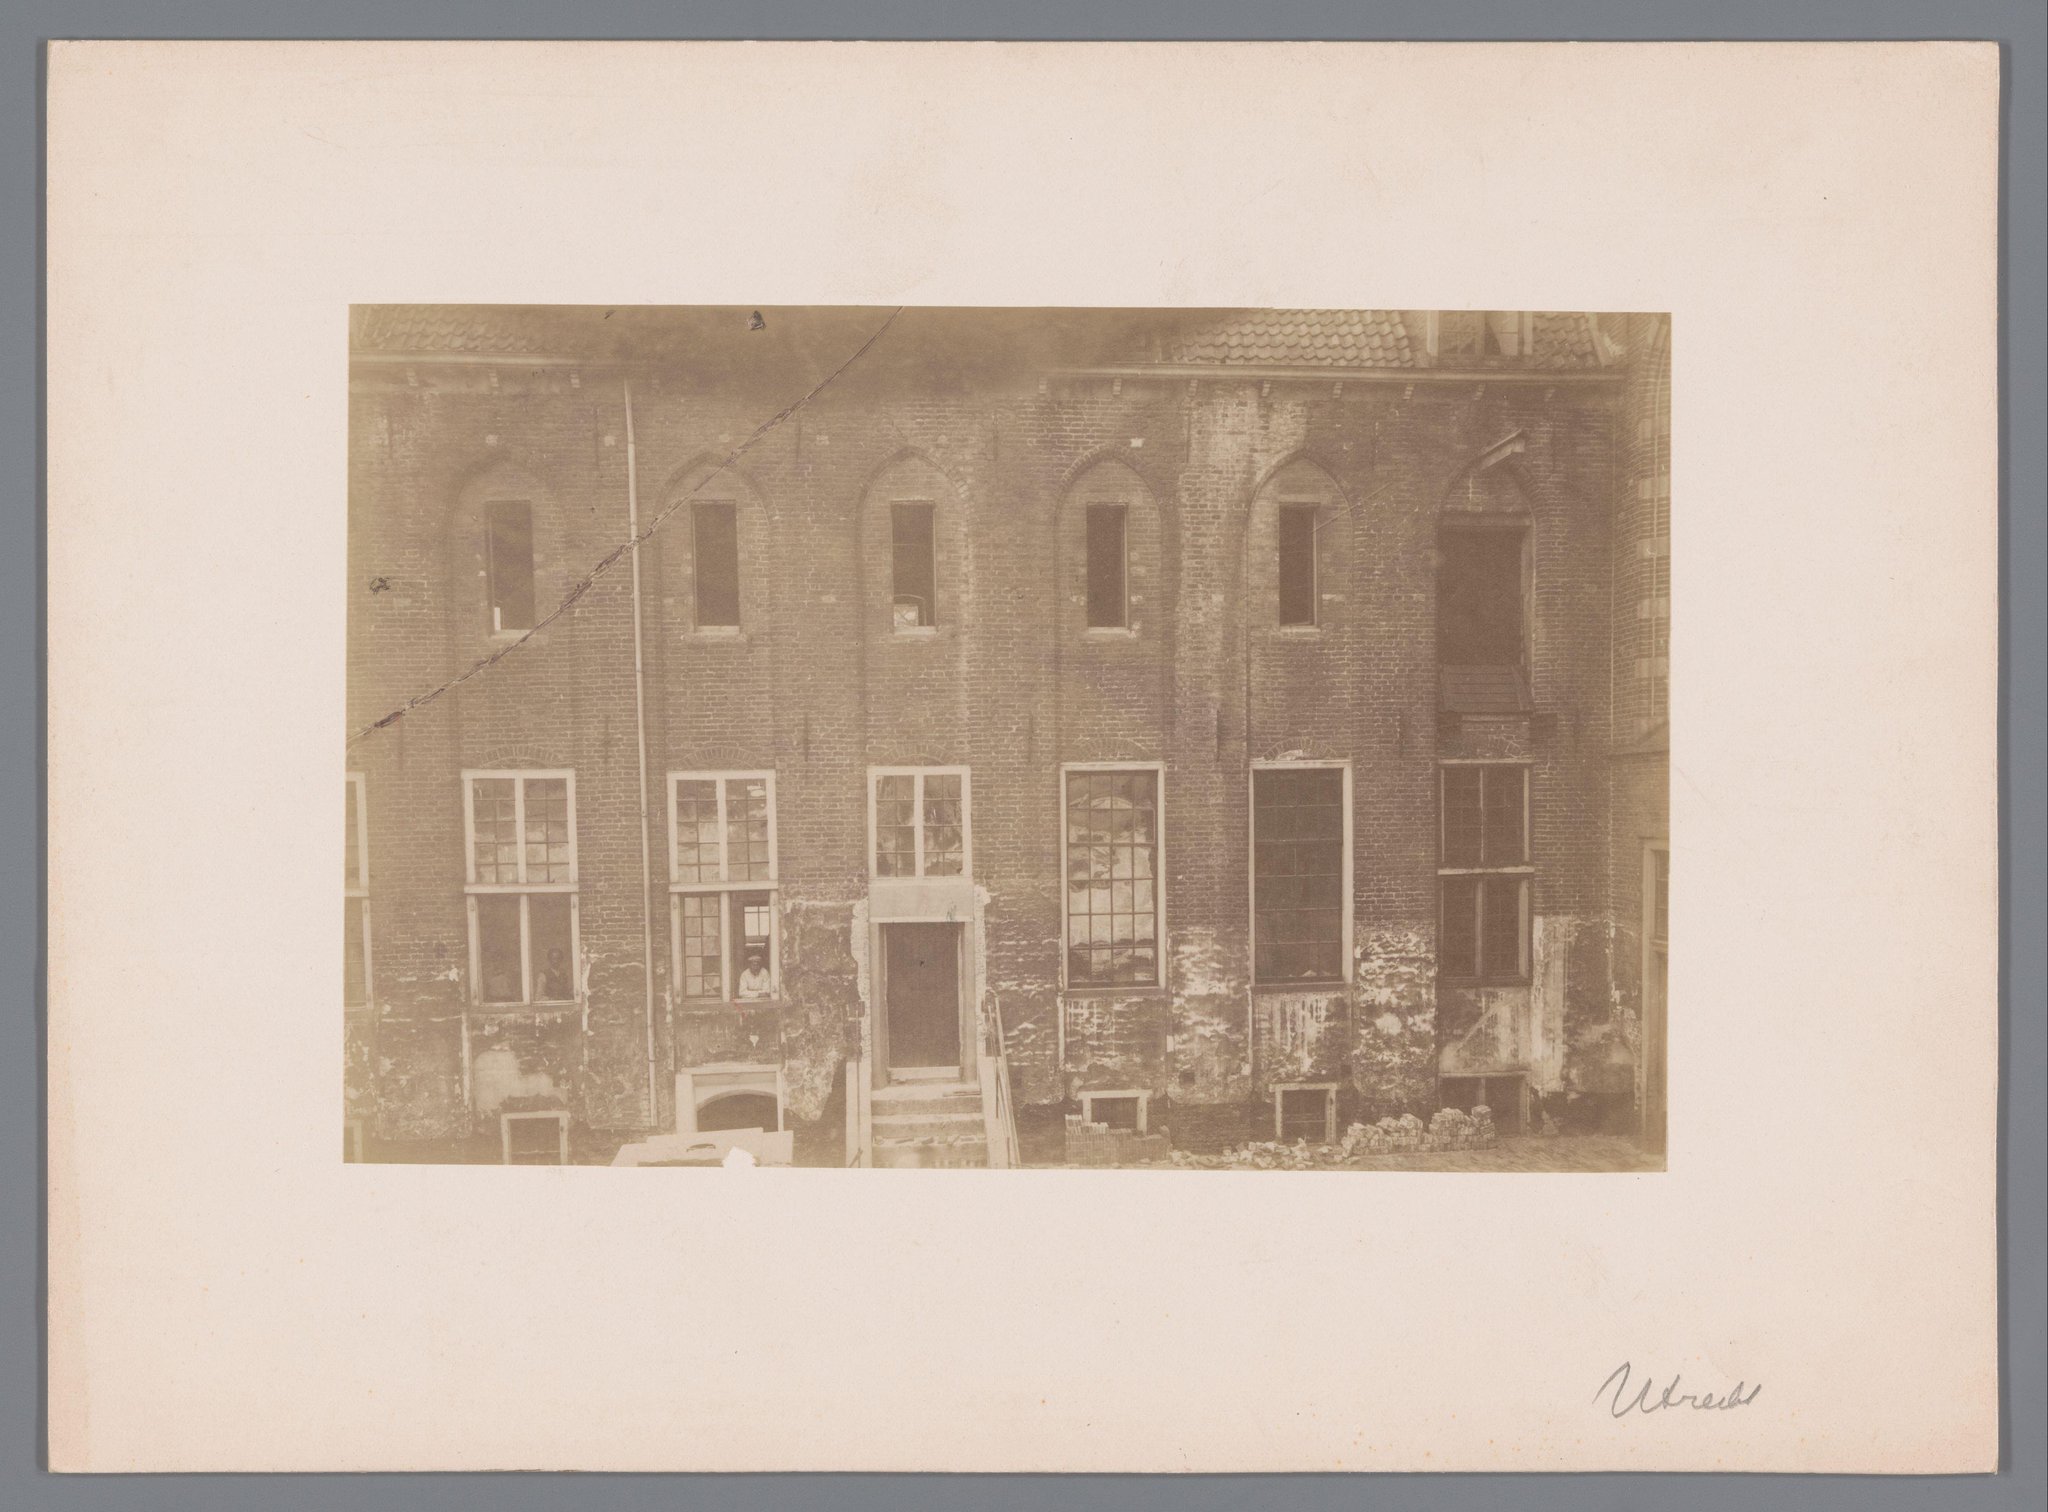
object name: photograph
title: Voormalige Agnietenklooster te Utrecht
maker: anoniem (monumentenzorg)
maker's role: fotograaf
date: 1902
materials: cardboard, photographic support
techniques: albumen print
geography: utrecht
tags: cloisters ~ monastery, utrecht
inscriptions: annotation: ‘Utrecht/ Voormalig st. Agnietenklooster thans militair gebouw/ gedeelte grenzende a/d kerk/ juni 1902’, annotation: ‘Utrecht’